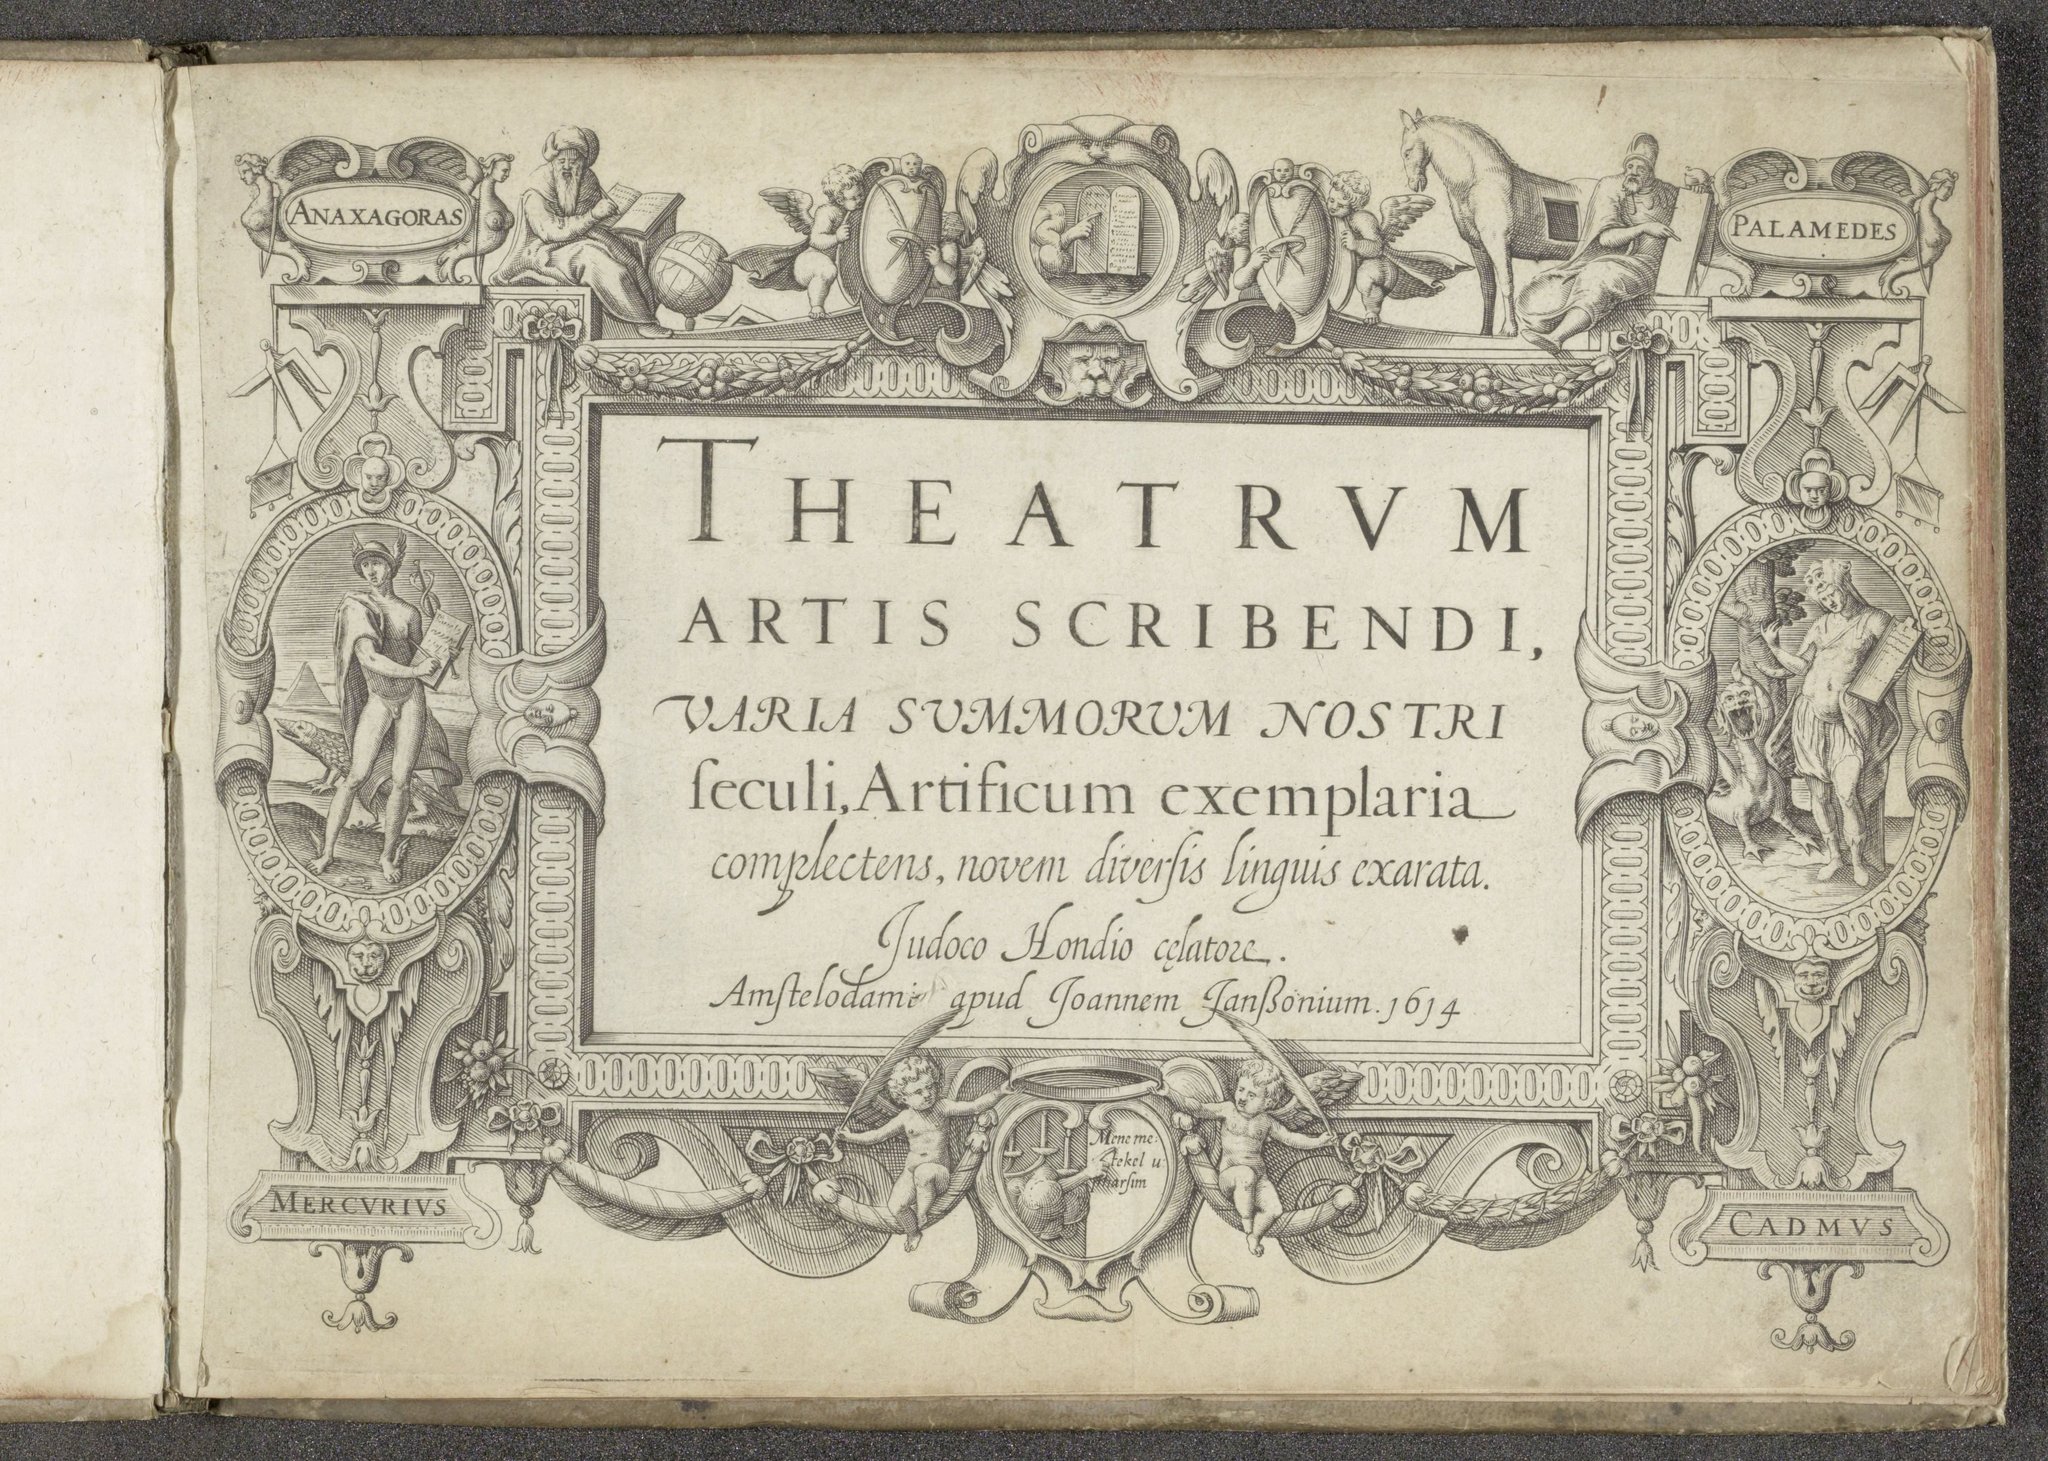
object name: print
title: Theatrum artis scribendi, varia summorum nostri seculi, Artificum exemplaria complectens, novem diversis linguis exarata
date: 1614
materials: paper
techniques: engraving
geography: amsterdam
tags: the trojan horse, (story of) mercury (hermes), (story of) cadmus, title-page, ornament ~ cartouche, hand, 'dextera dei' ~ symbol of god the father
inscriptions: signature and date: ‘Op titelblad: Judoco Hondio celatore. Amstelodami apud Joannem Janssonium. 1614’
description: Cartouche met een serietitel en een impressum. Bovenaan in de omlijsting wijst de vinger van God de tekst aan op de Tafelen der Wet. Daarbij twee putti met een schild waarop twee gekruiste schrijfpennen in een ring. Onderaan de vinger van God bij het teken aan de wand uit het bijbelboek Daniël (Mene tekel upharsim), gekroond door twee putti met een schrijfpen in de hand. Verder de Griekse filosoof en astronoom Anaxagoras, schrijvend in een boek naast een globe. Rechtsboven de Griek Palamedes naast het paard van Troje. De titel wordt geflankeerd door een schrijvende Mercurius, met een piramide en krokodil op de achtergrond. Aan de andere kant staat een schrijvende Cadmus en de draak die hij moest doden om zijn tanden te zaaien. De prent maakt deel uit van een album.